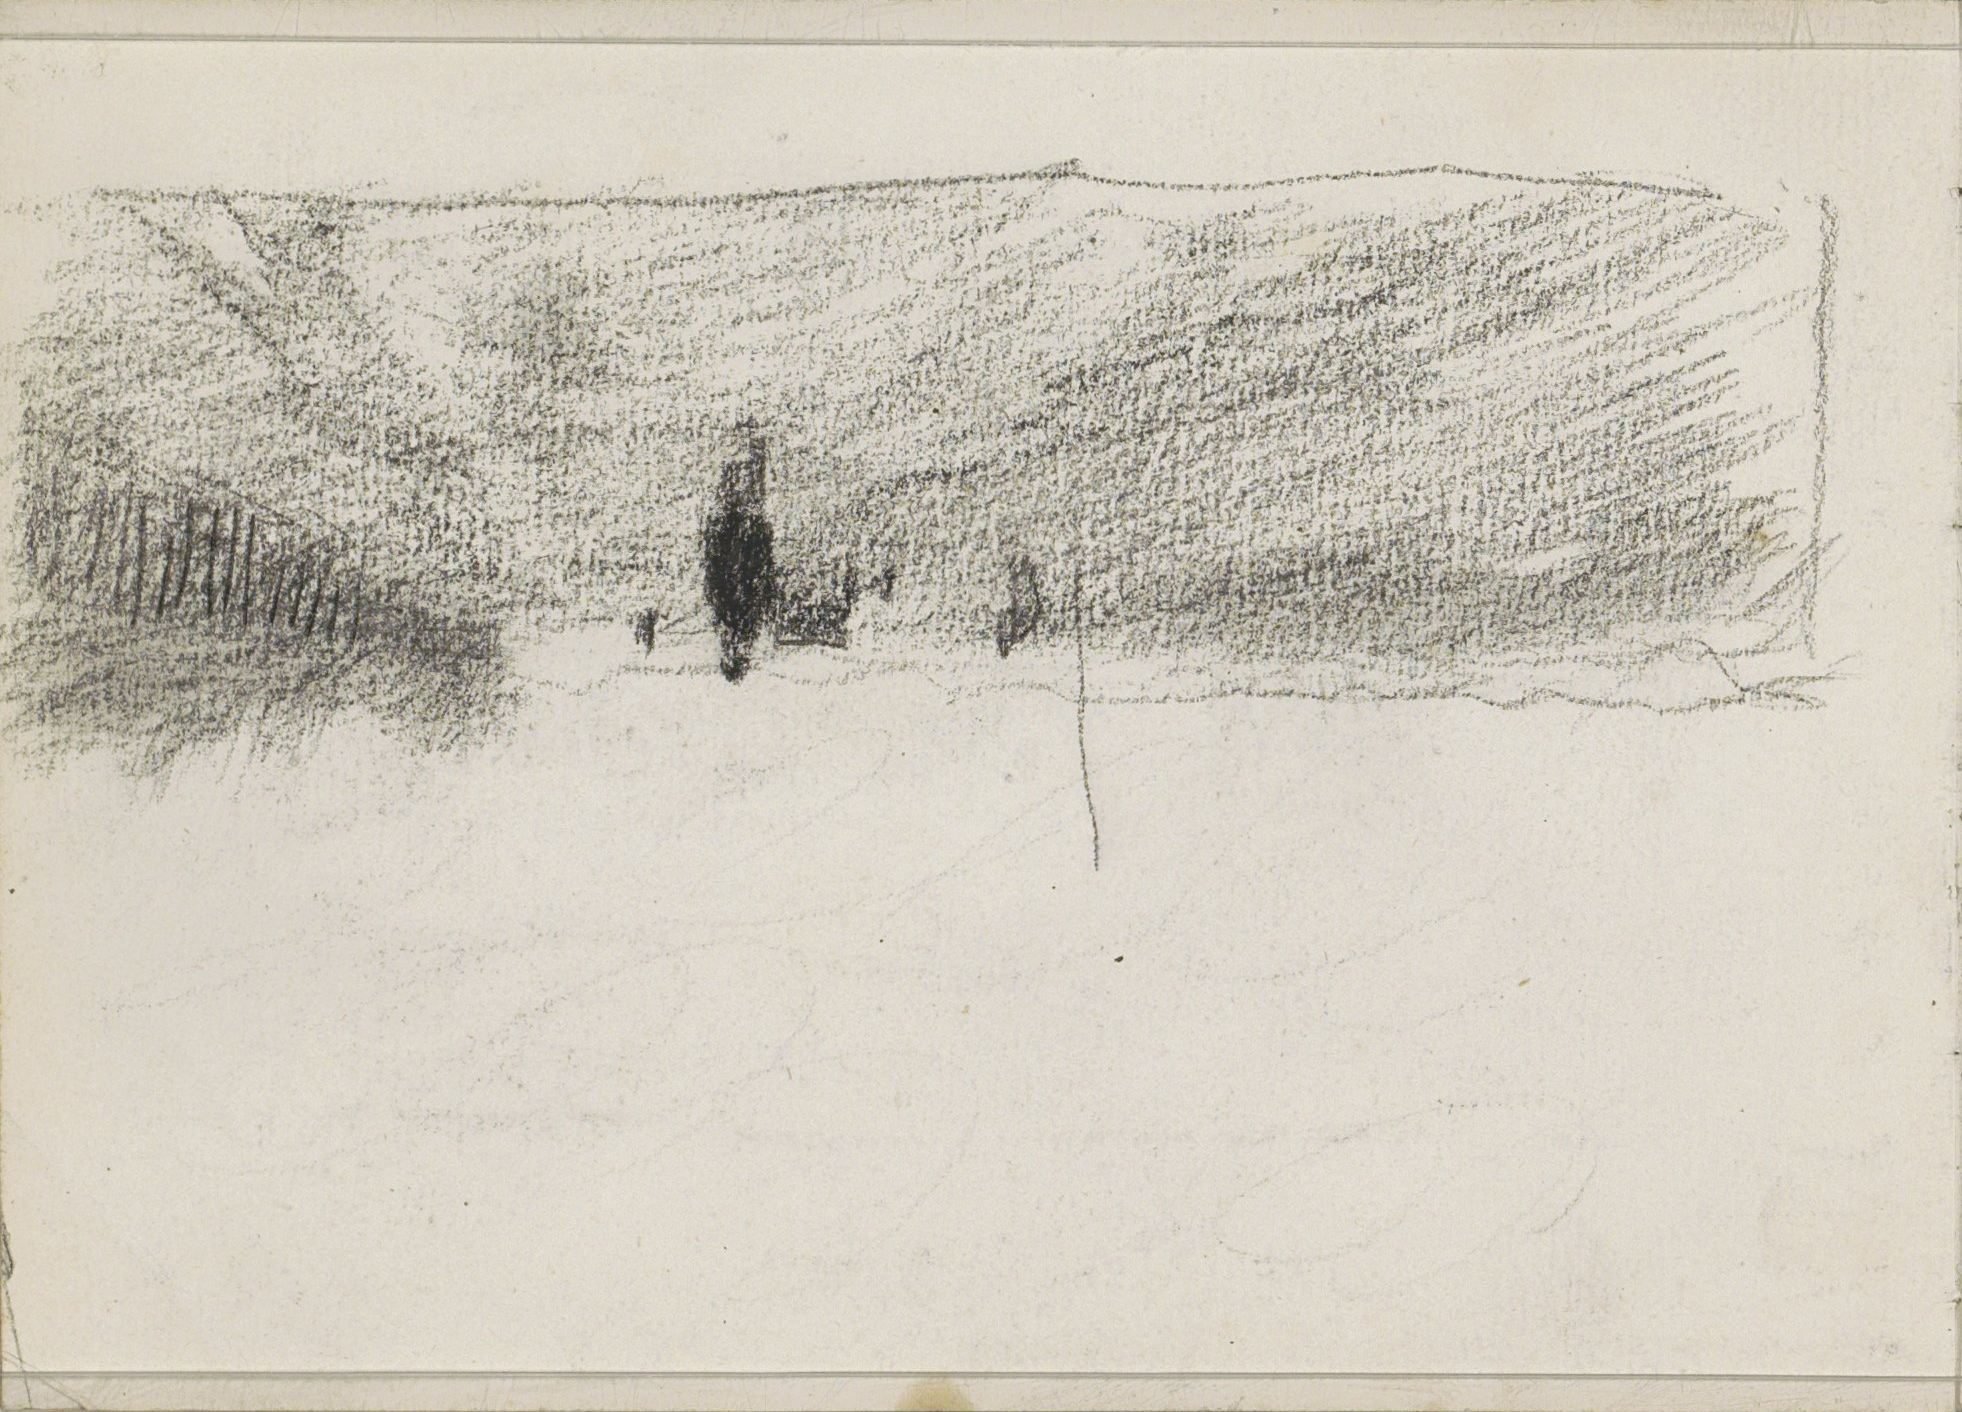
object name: sketchbook leaf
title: Figuren met een kar in een veld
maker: anton mauve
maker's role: draughtsman, painter, print maker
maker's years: 1838-1888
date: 1848-1888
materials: chalk, paper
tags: landscapes (+ landscape with figures, staffage)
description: Vermoedelijk werken de figuren op het land. Blad 5 verso uit een schetsboek met 31 bladen.